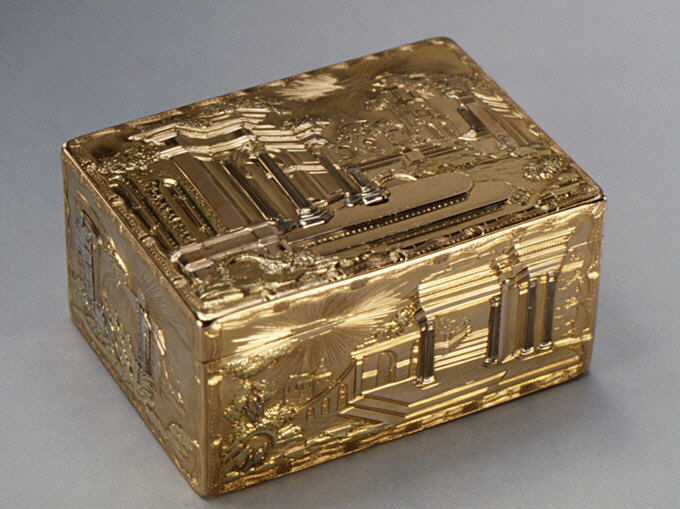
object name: snuffbox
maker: louis charonnat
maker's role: maker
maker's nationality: french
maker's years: 1748-1780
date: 1758-1759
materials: gold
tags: ruins